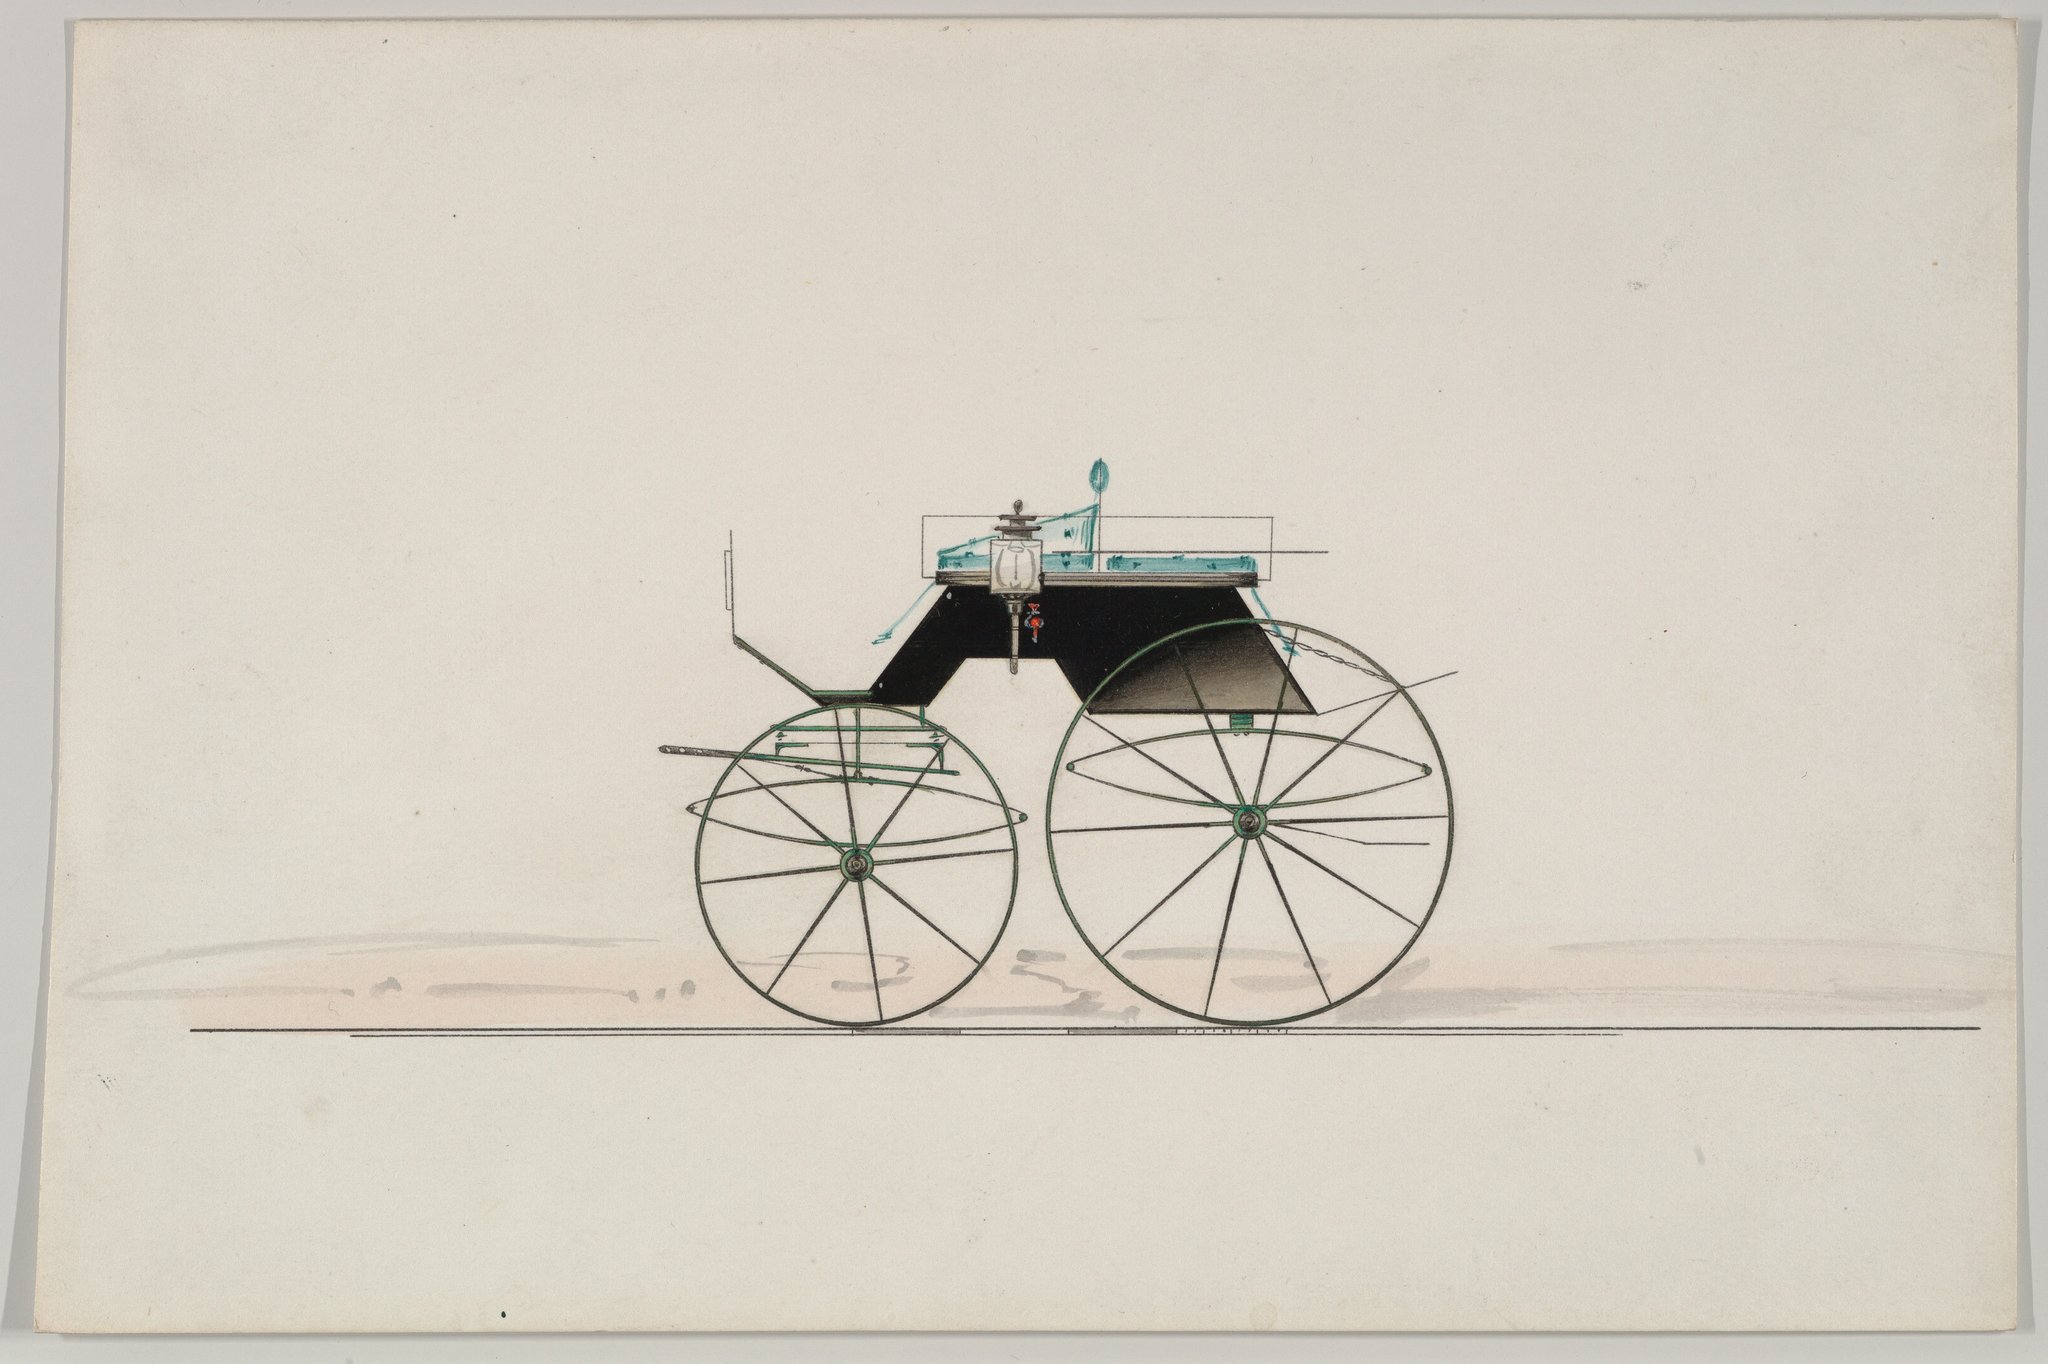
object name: drawing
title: Dog Cart Phaeton (unnumbered)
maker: brewster & co.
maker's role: manufacturer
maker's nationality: american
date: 1850-1870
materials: gouache, gum arabic, ink, watercolor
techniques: pen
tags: carriages